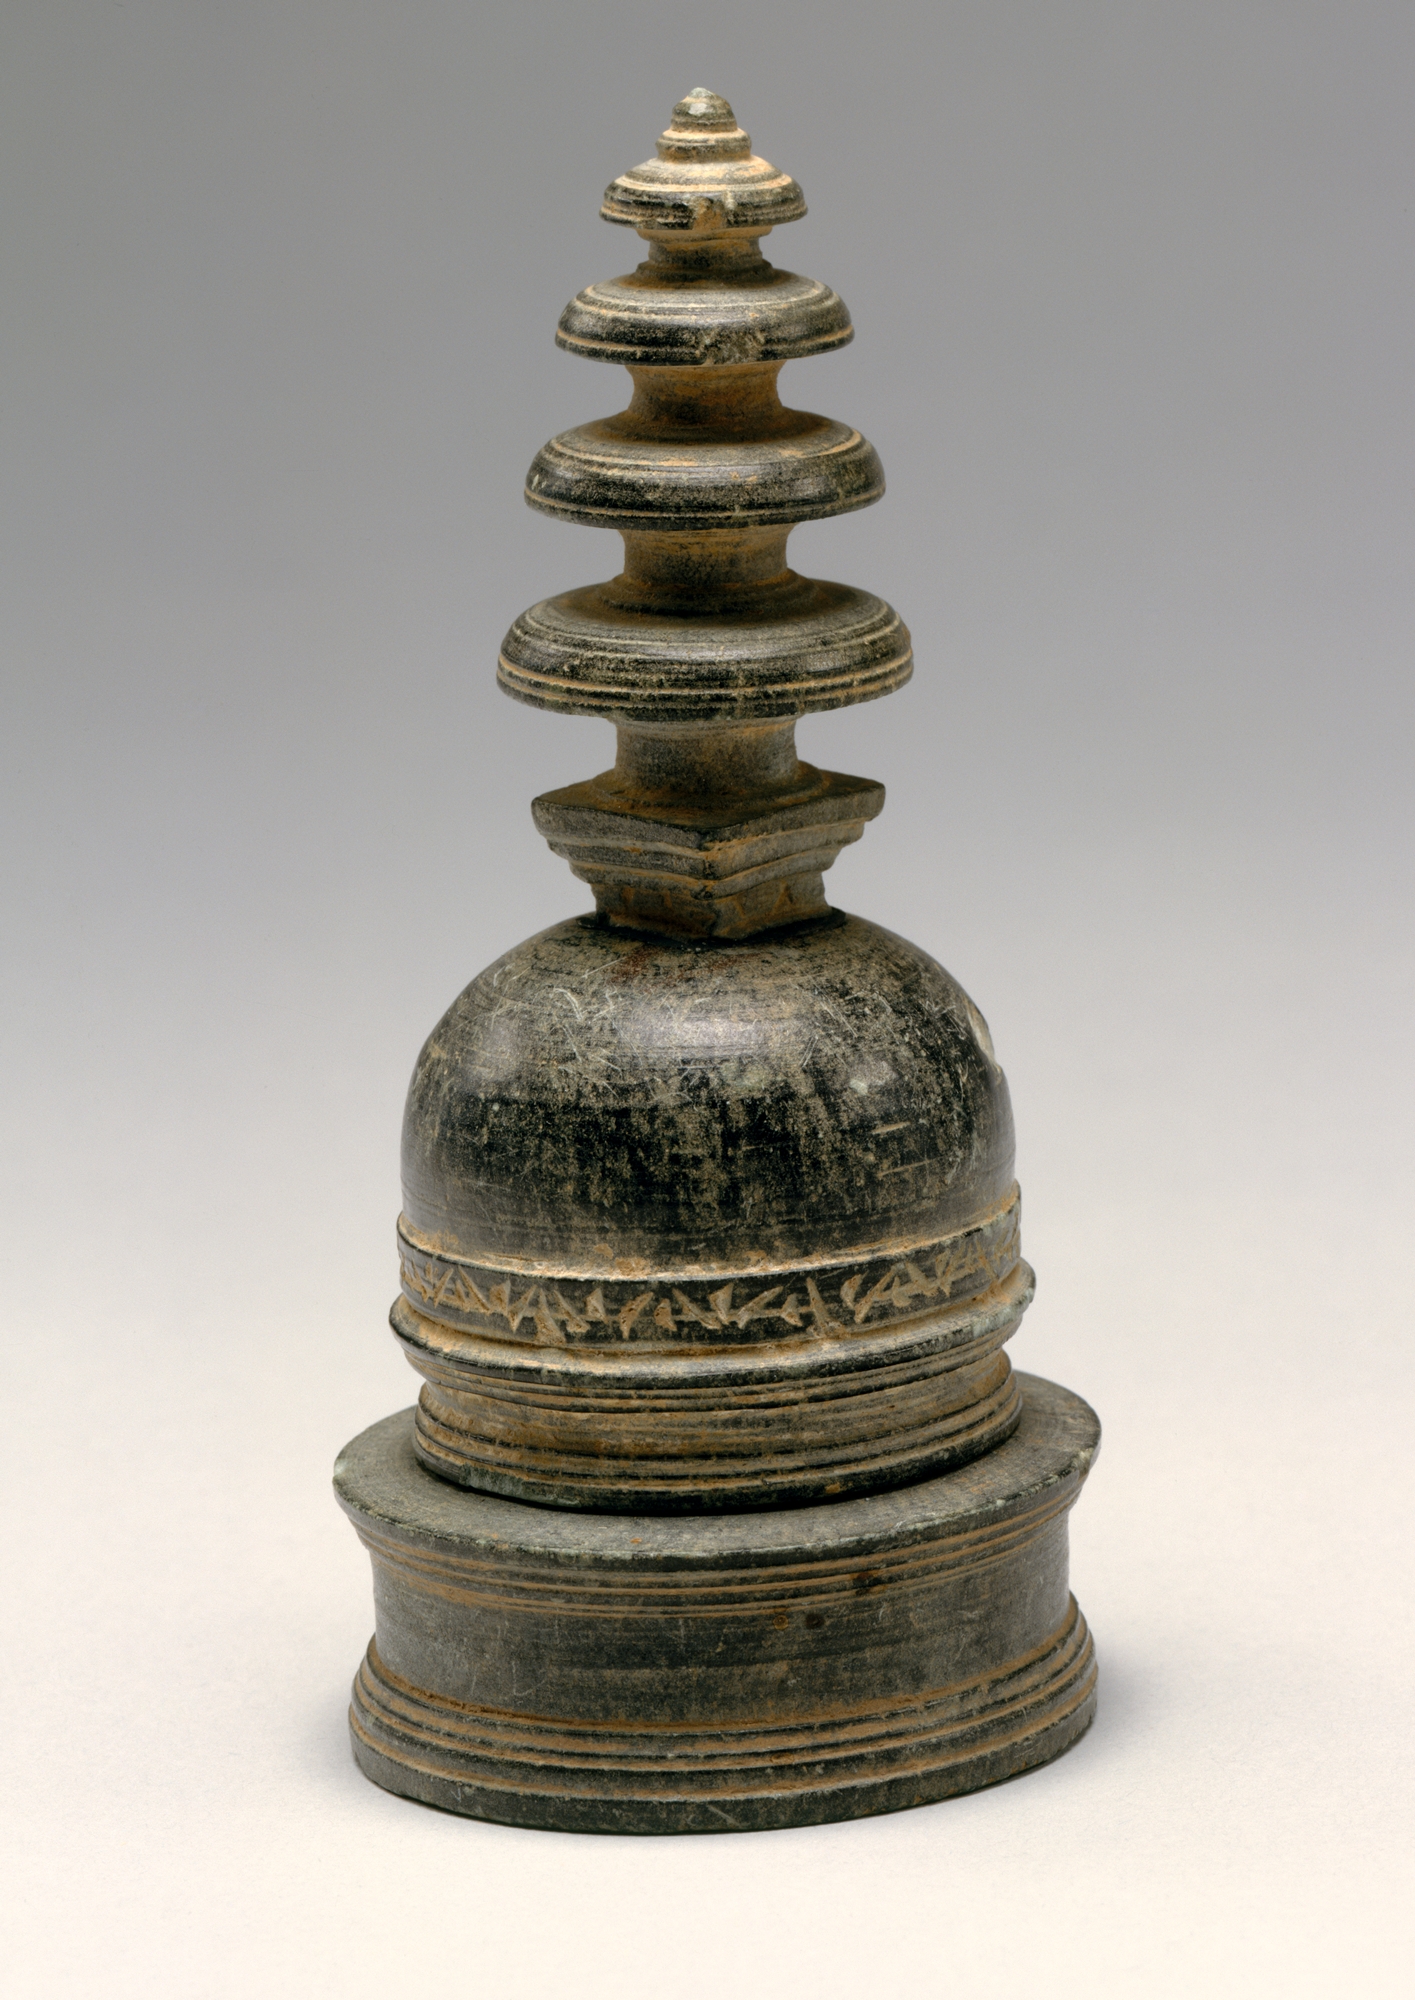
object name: reliquary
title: Reliquary in the Shape of a Stupa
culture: gandhara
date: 1-100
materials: stone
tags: gandhara